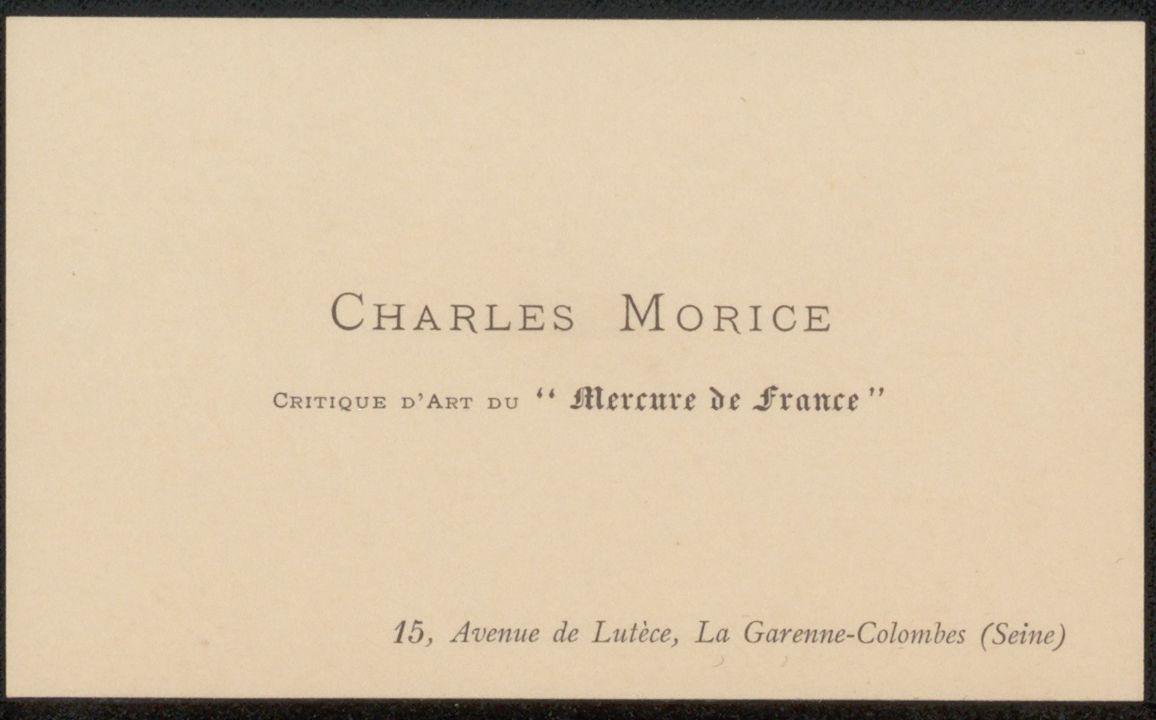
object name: visiting card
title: Visitekaartje aan Philip Zilcken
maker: charles morice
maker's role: dichter, essayist, kunstcriticus, schrijver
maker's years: 1860-1919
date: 1870-1919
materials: cardboard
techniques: printing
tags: painter, draughtsman, philip zilcken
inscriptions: collector's mark: ‘RPK’